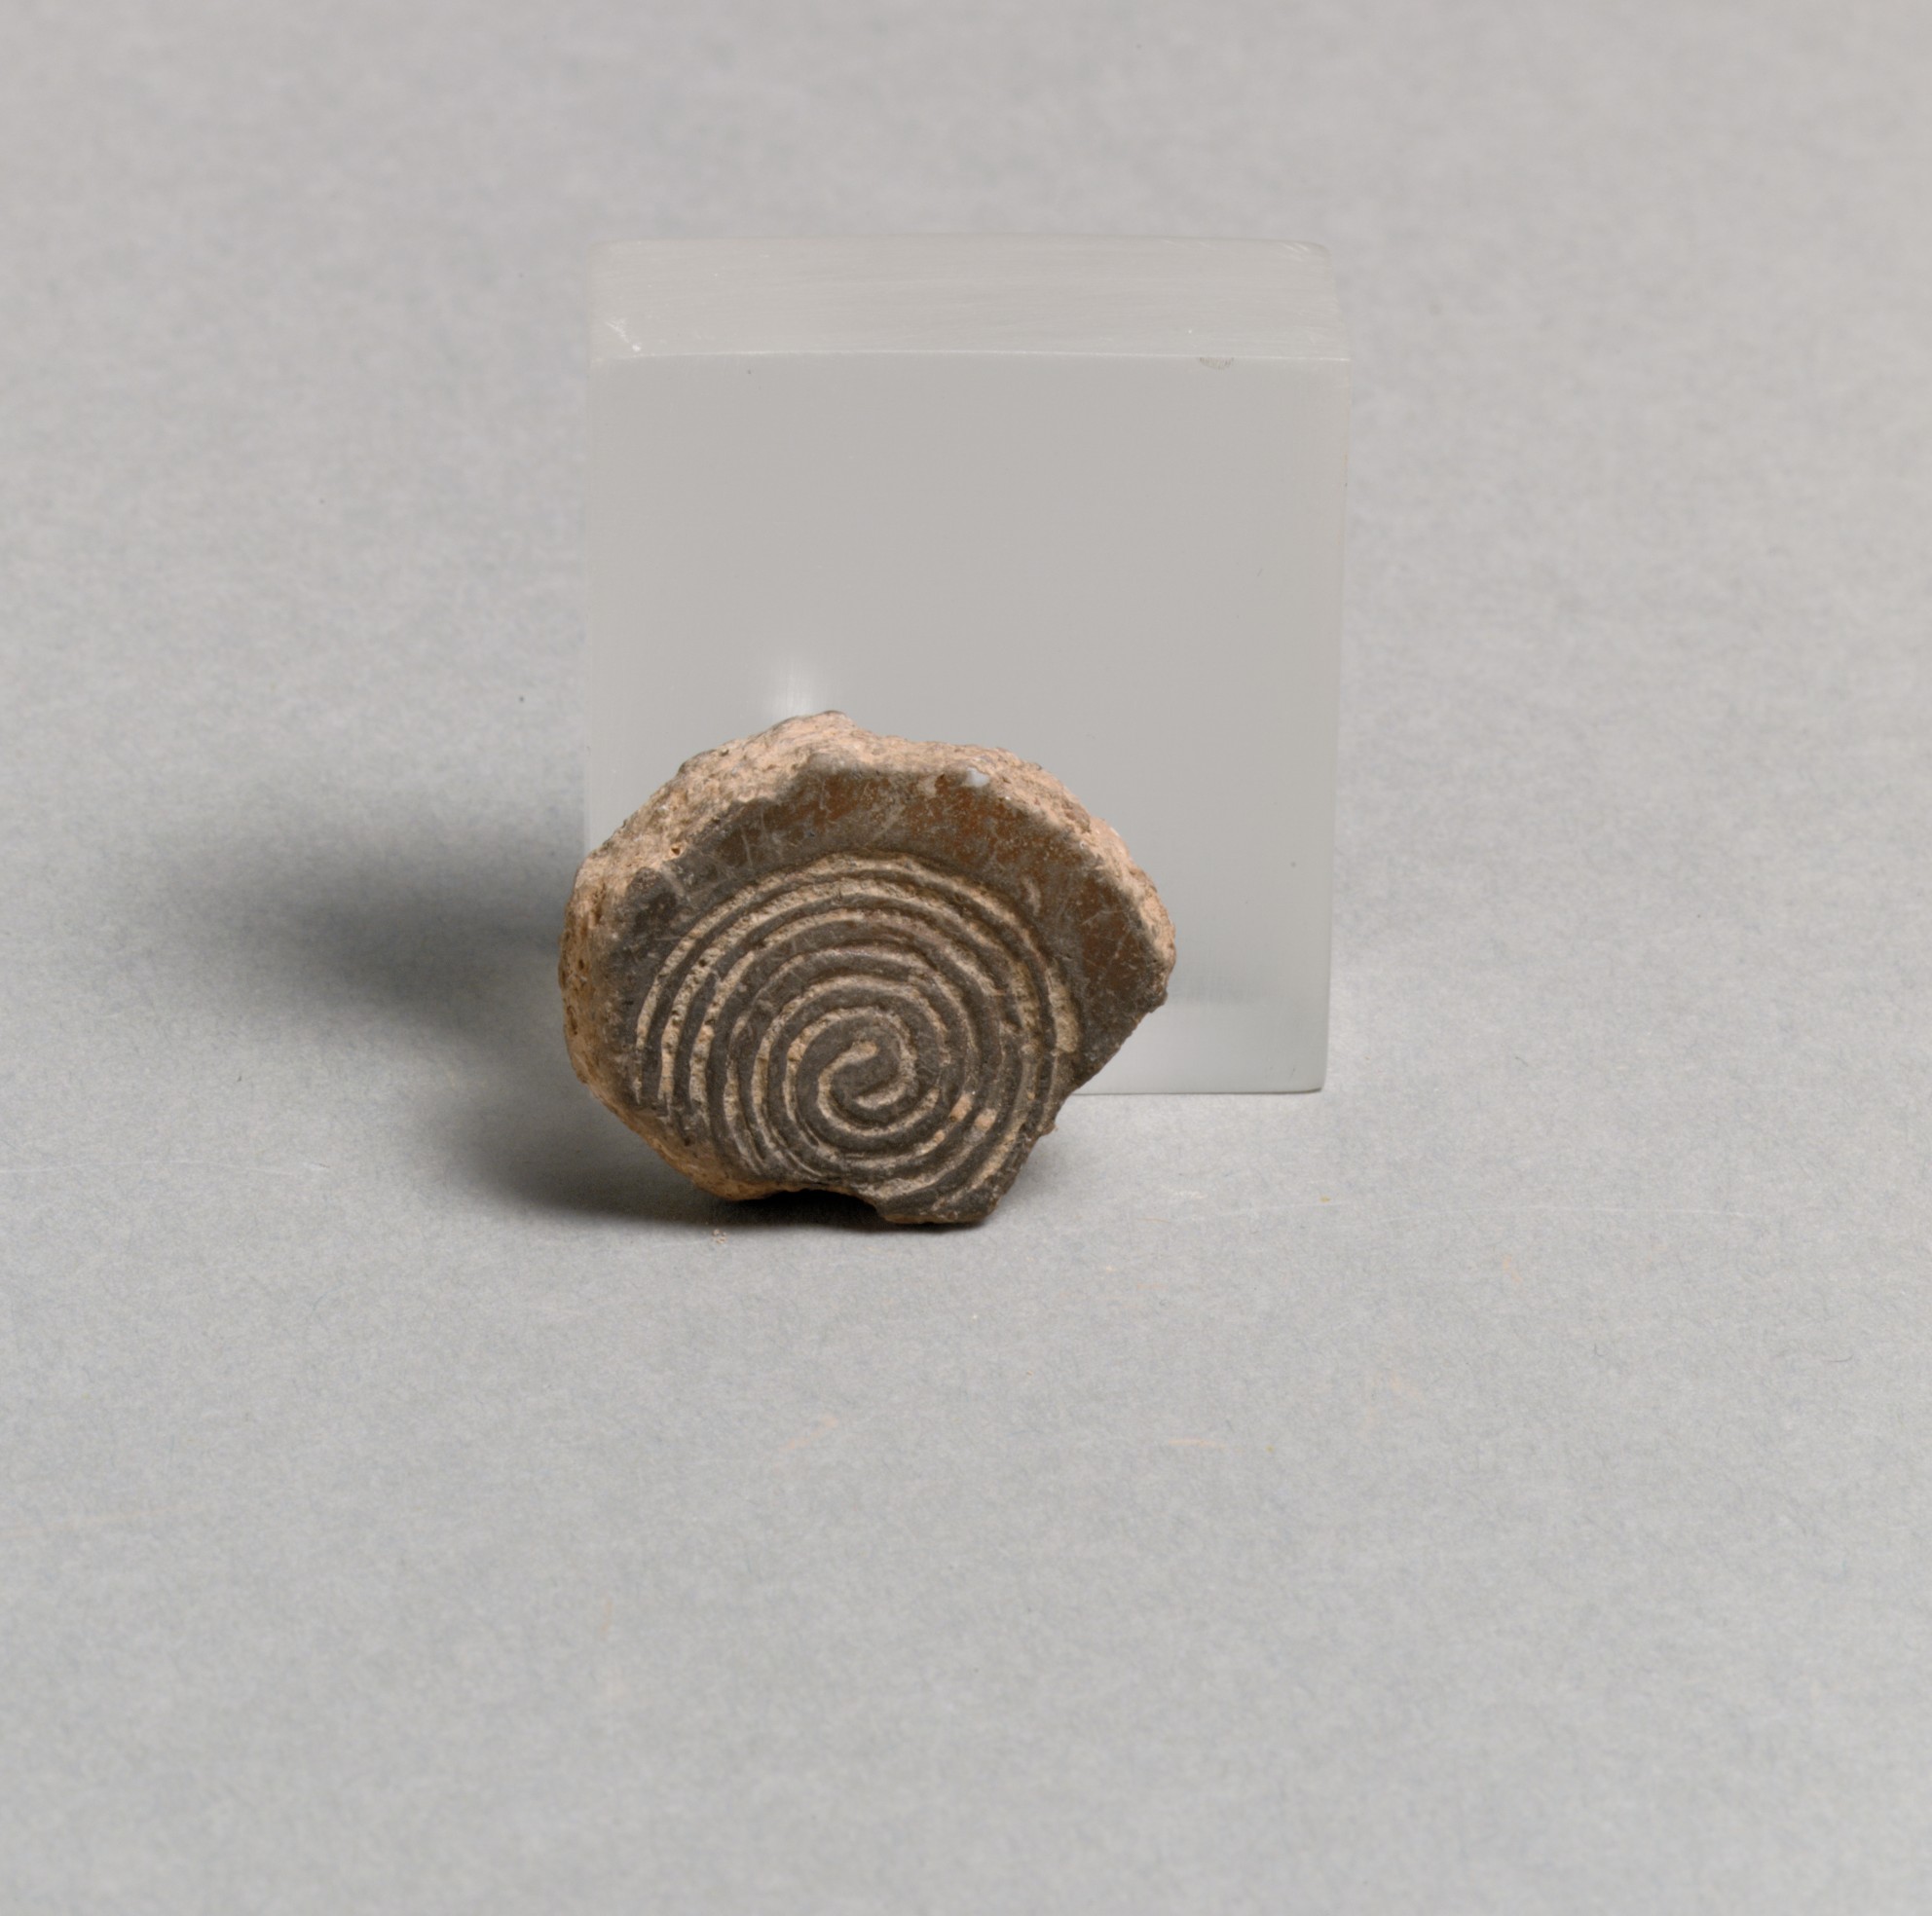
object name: vase fragment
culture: aegean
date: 3000-2000 BCE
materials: terracotta